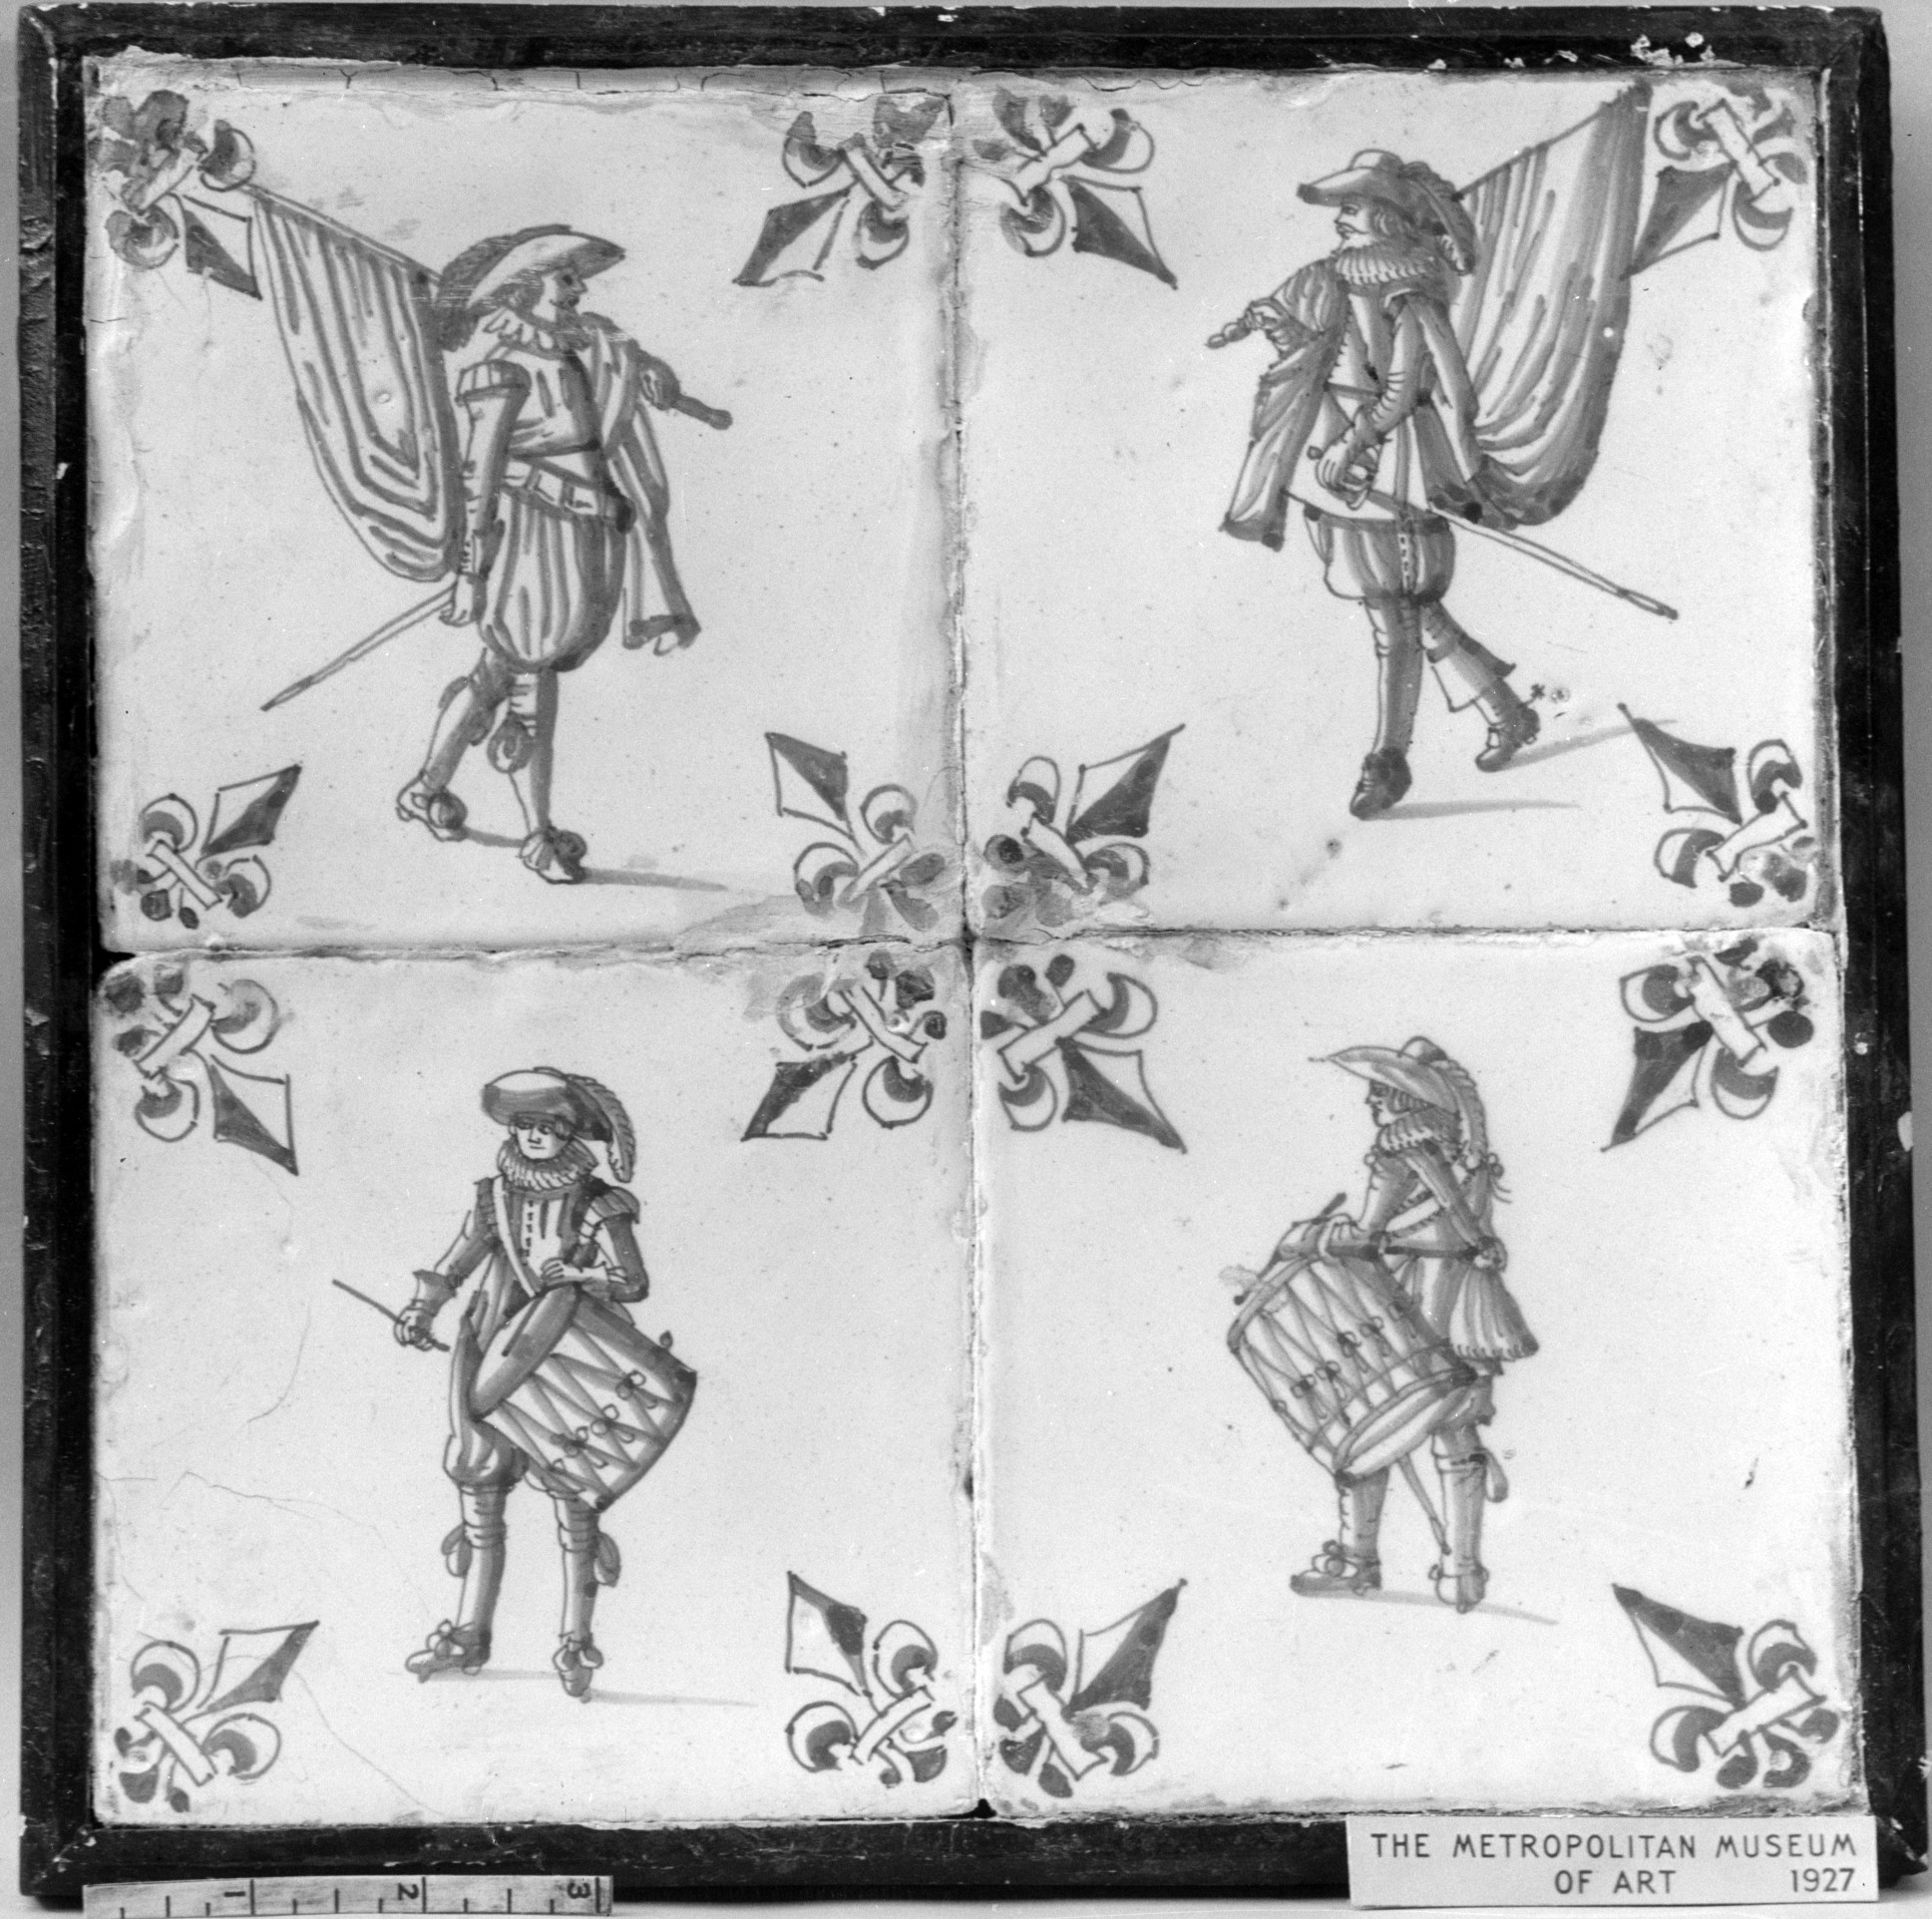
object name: tile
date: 1701-1900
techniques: glazing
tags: swords,men,drums